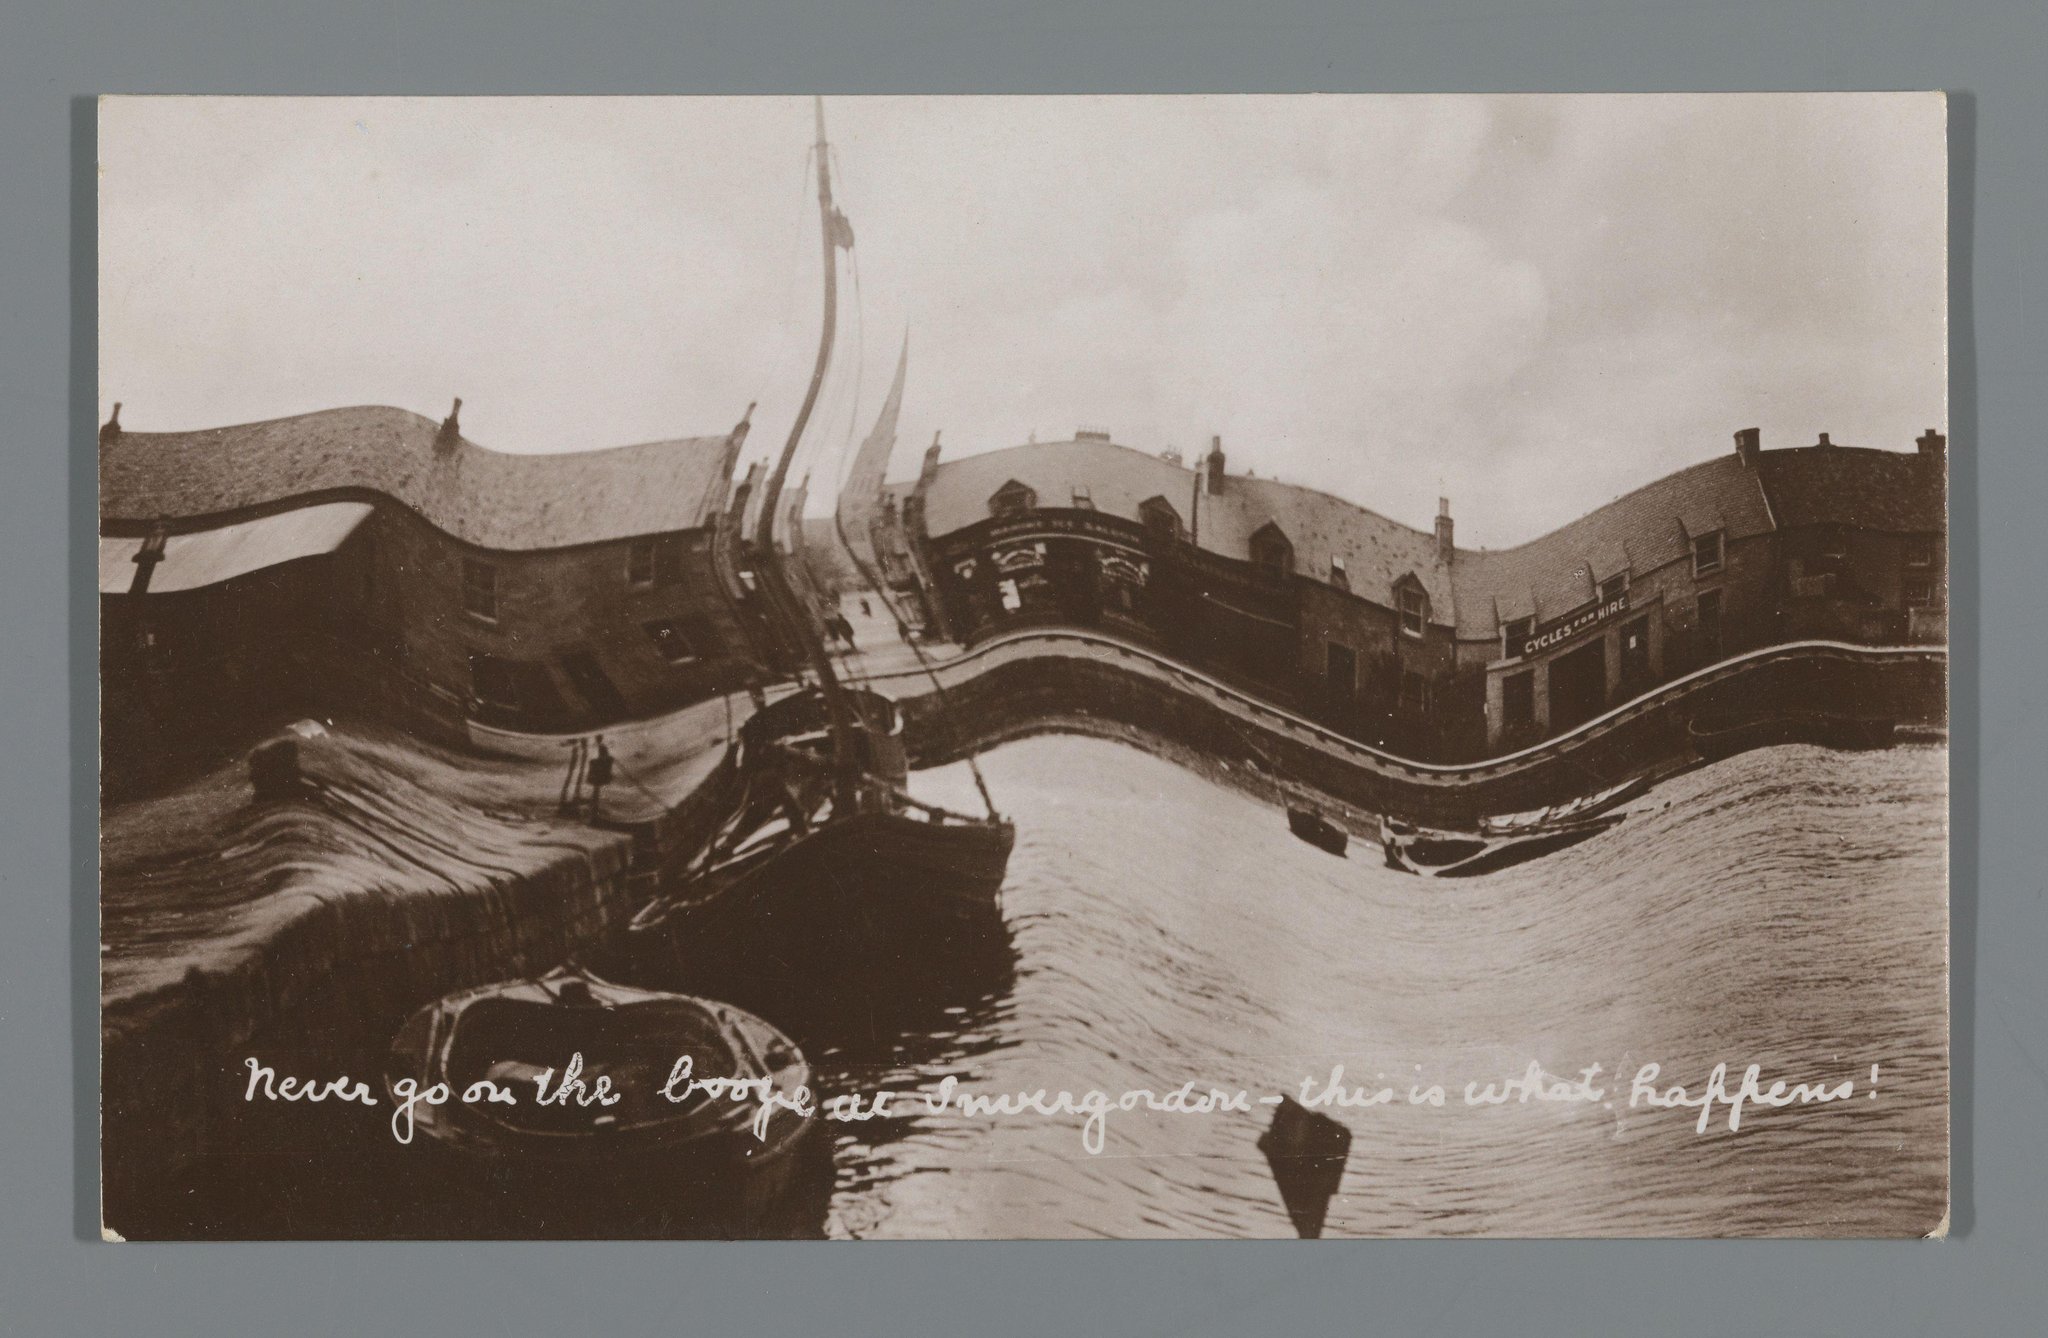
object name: photograph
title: Davidson’s Real Photographic Series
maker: Anonymous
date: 1905-1920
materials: paper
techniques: gelatin silver print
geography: london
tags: harbour, drunkenness